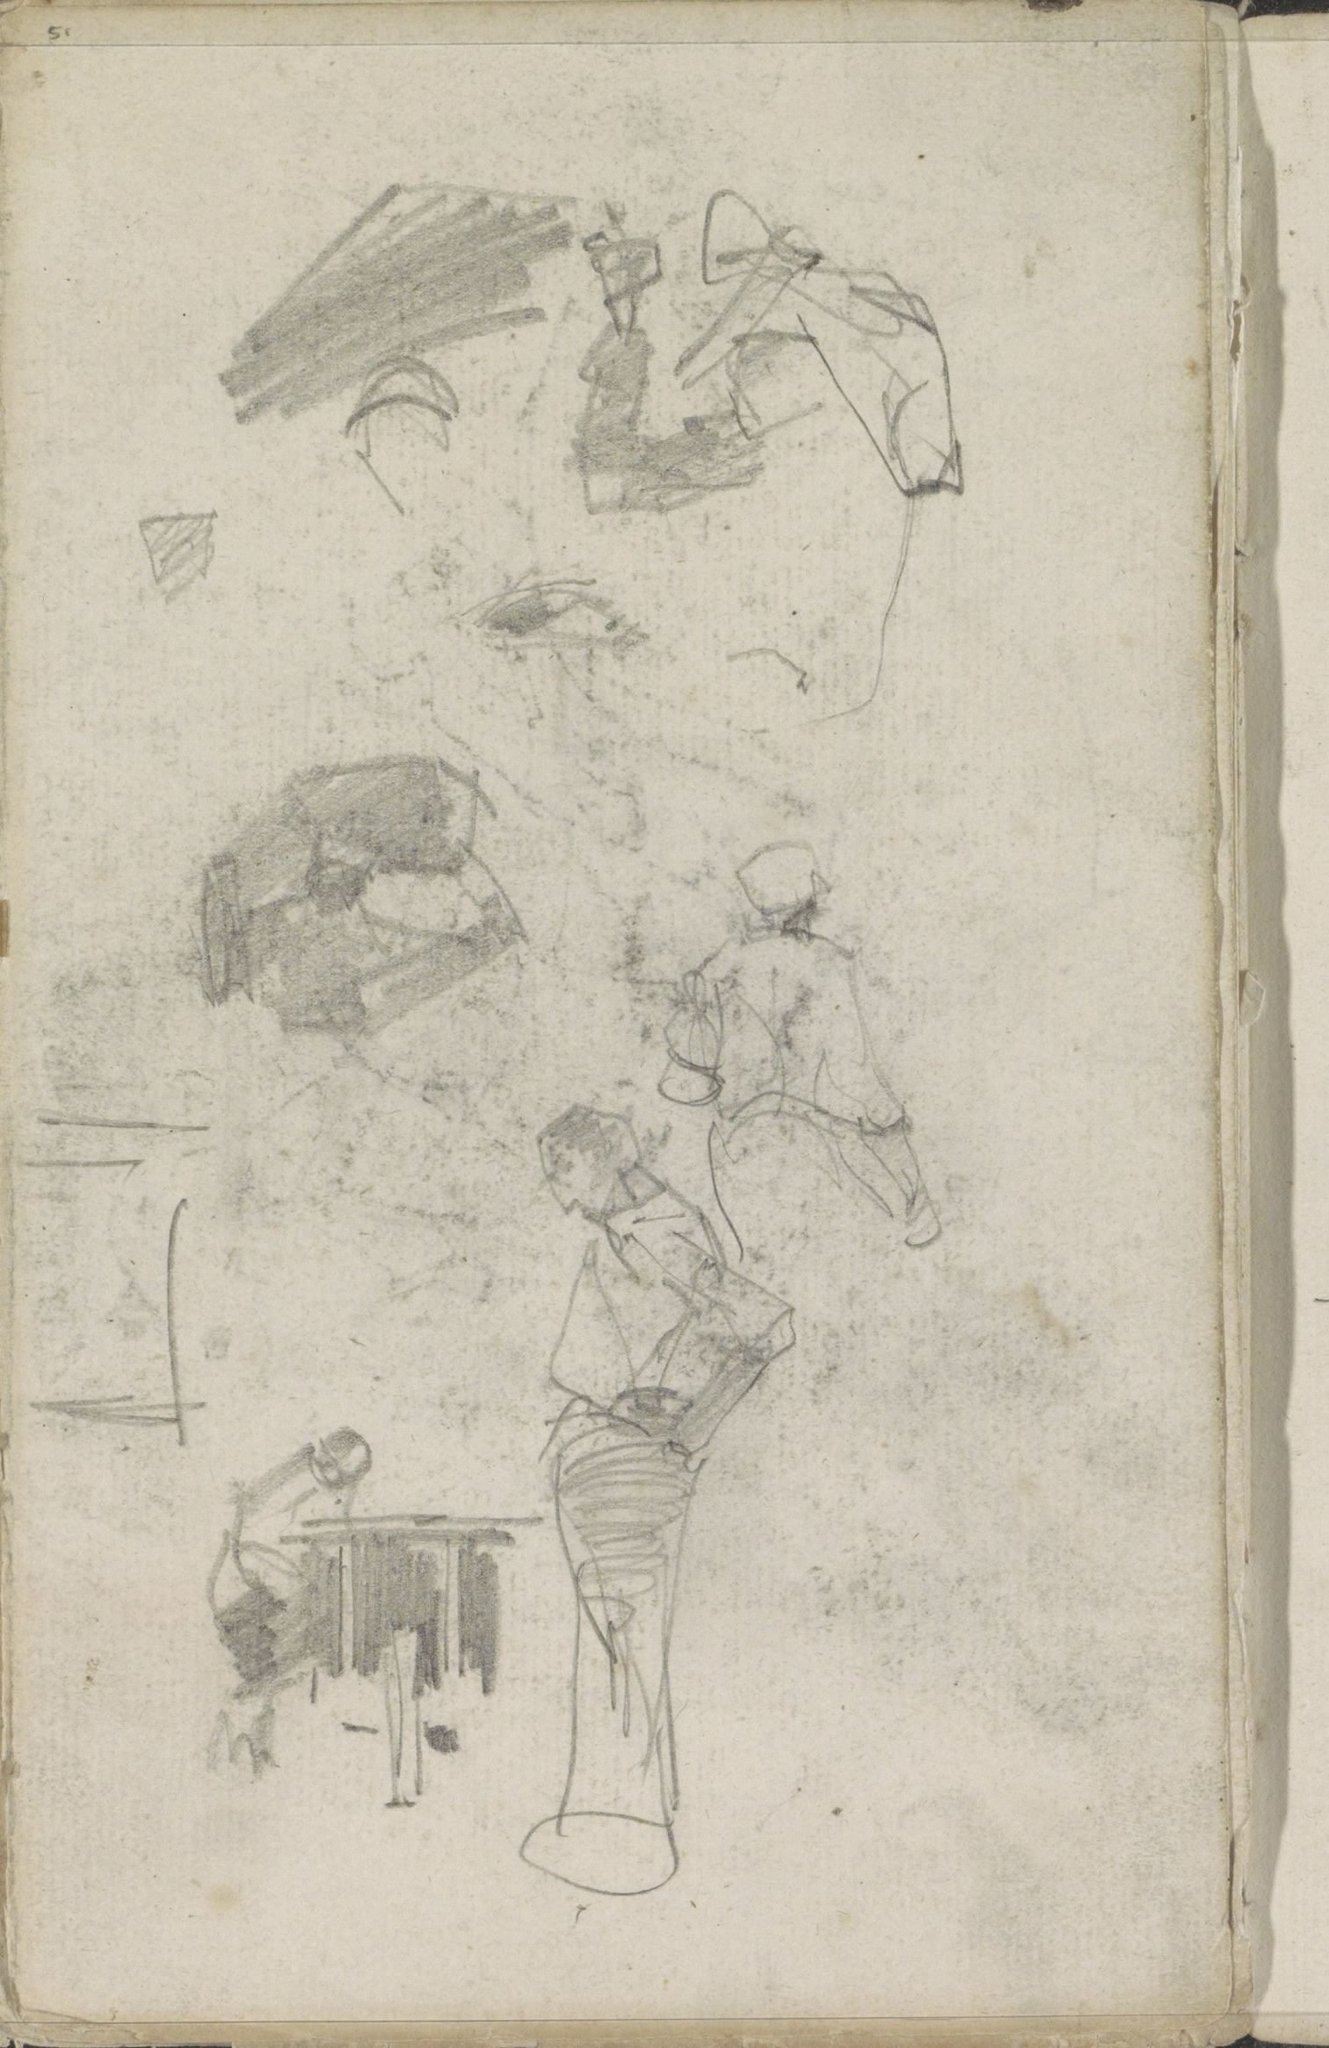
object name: sketchbook leaf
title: Figuurstudies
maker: george hendrik breitner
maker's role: draughtsman, painter, print maker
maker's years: 1857-1923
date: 1880-1882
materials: paper, pencil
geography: the hague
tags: adult woman, adult man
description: Pagina 51 uit een schetsboek met 29 bladen.